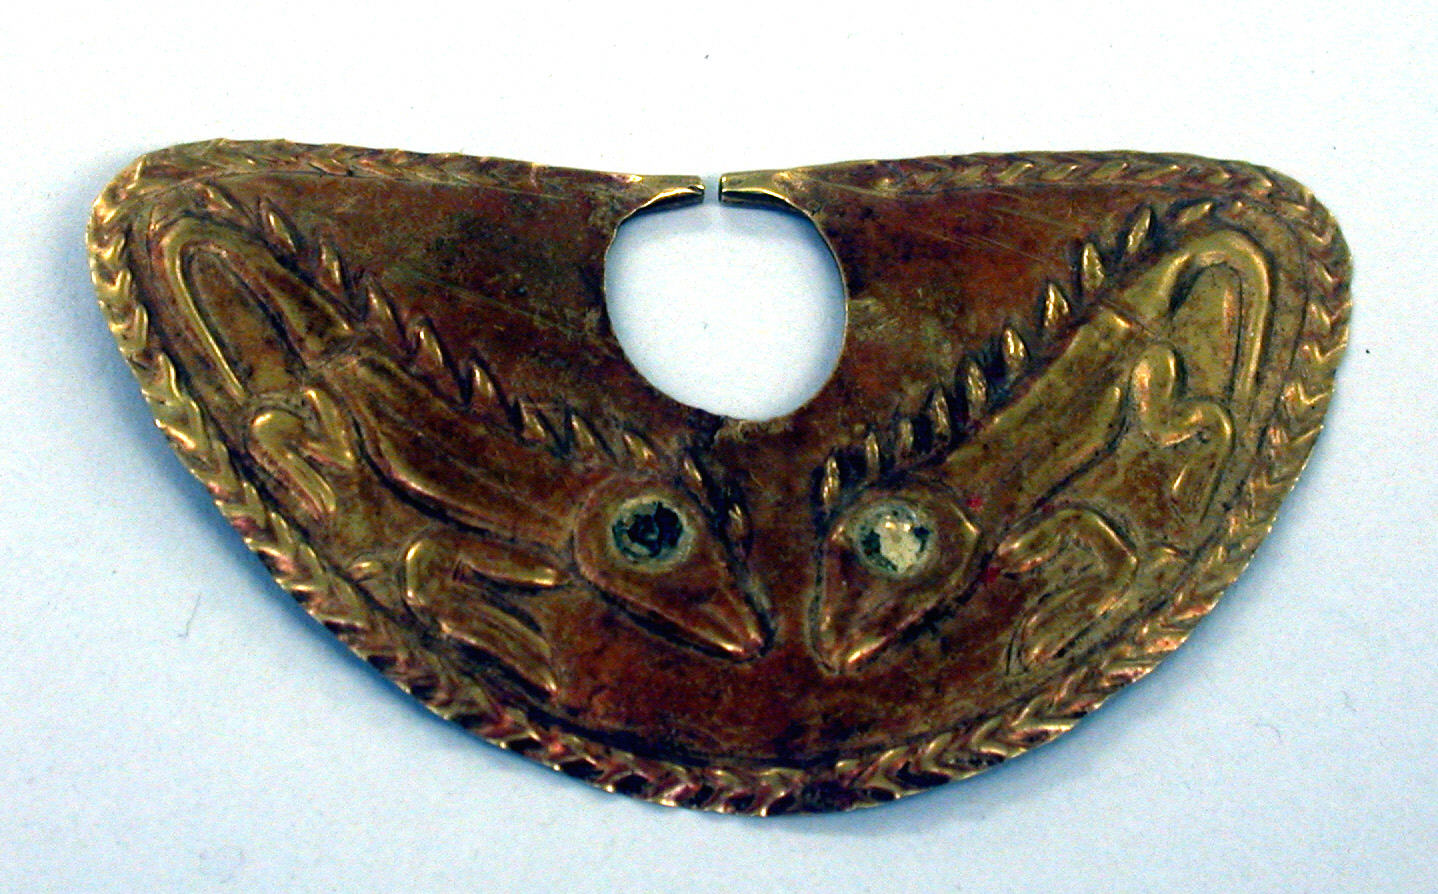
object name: nose ornament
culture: moche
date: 501-700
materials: gold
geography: peru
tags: lizards